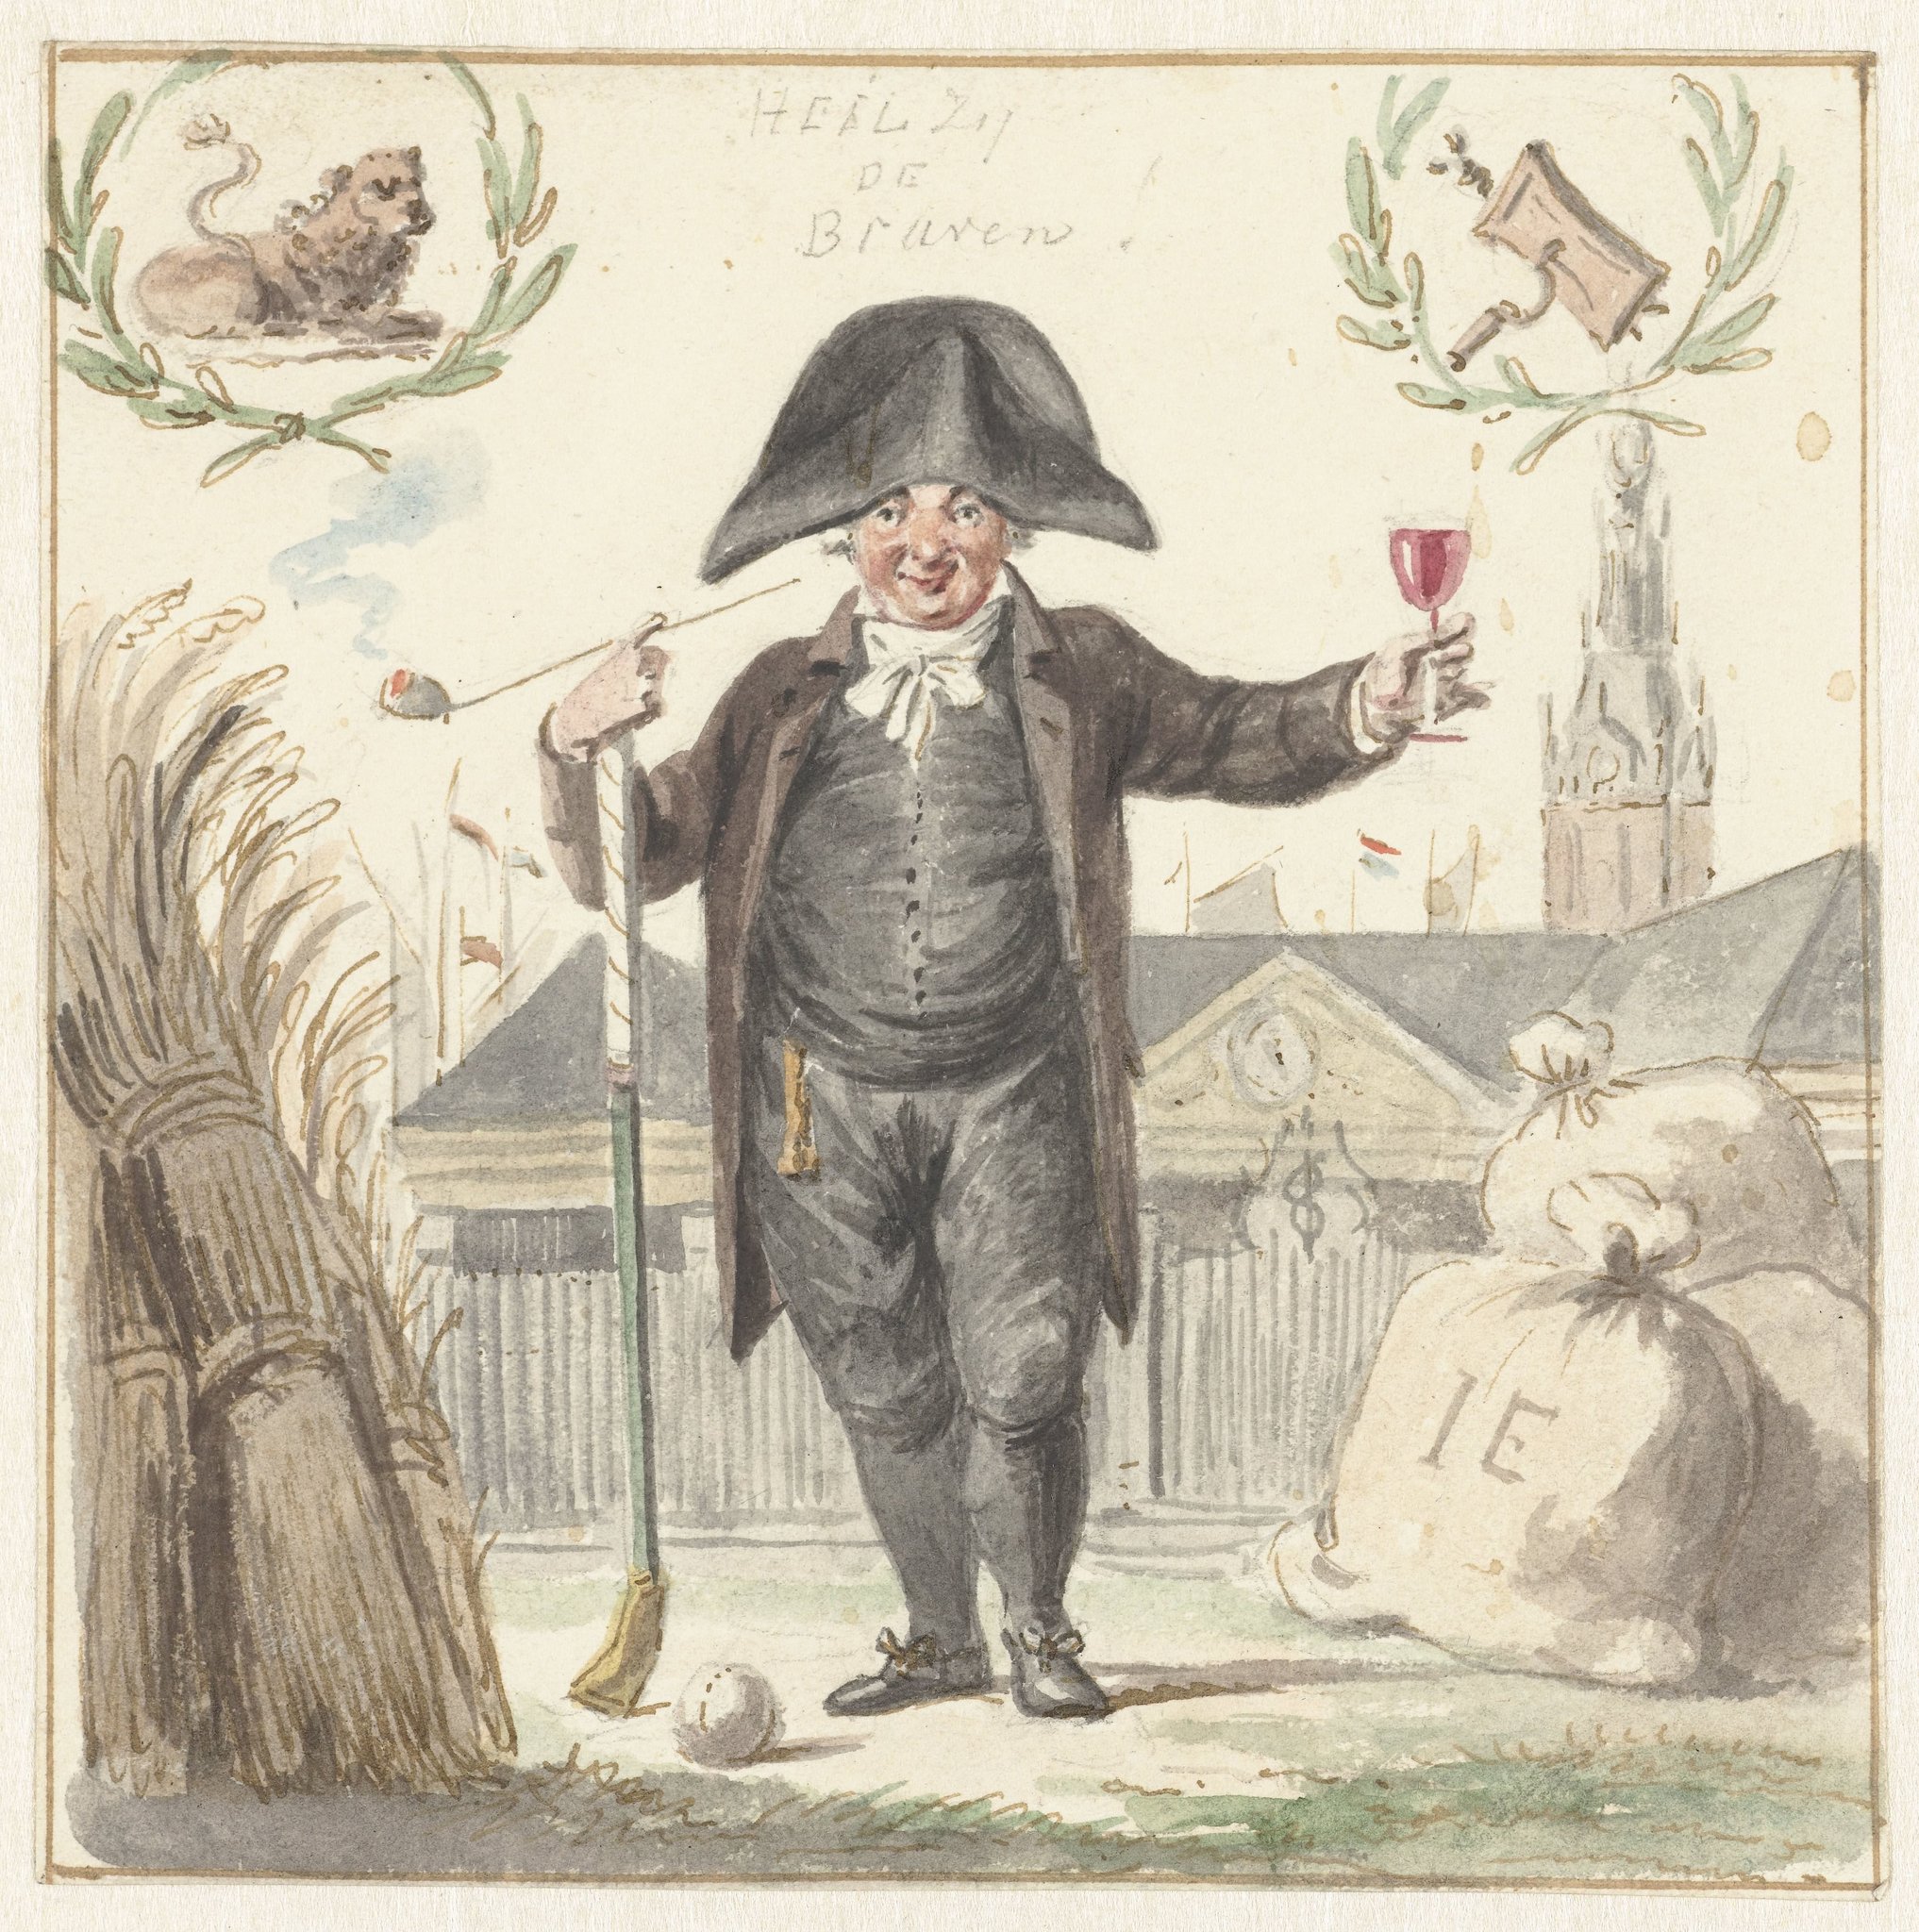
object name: drawing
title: Graanhandelaar Johan Eymer voor de Korenbeurs van Amsterdam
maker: jacob smies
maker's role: draughtsman, painter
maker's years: 1746-1833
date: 1774-1833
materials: paper, watercolor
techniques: brush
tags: historical persons, 'kolf' (ball game), amsterdam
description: De graanhandelaar Johan Eymer (1757-1830) met kolfstok, pijp en wijnglas voor de Korenbeurs van Amsterdam. Boven: HEIL ZIJ DE BRAVEN!